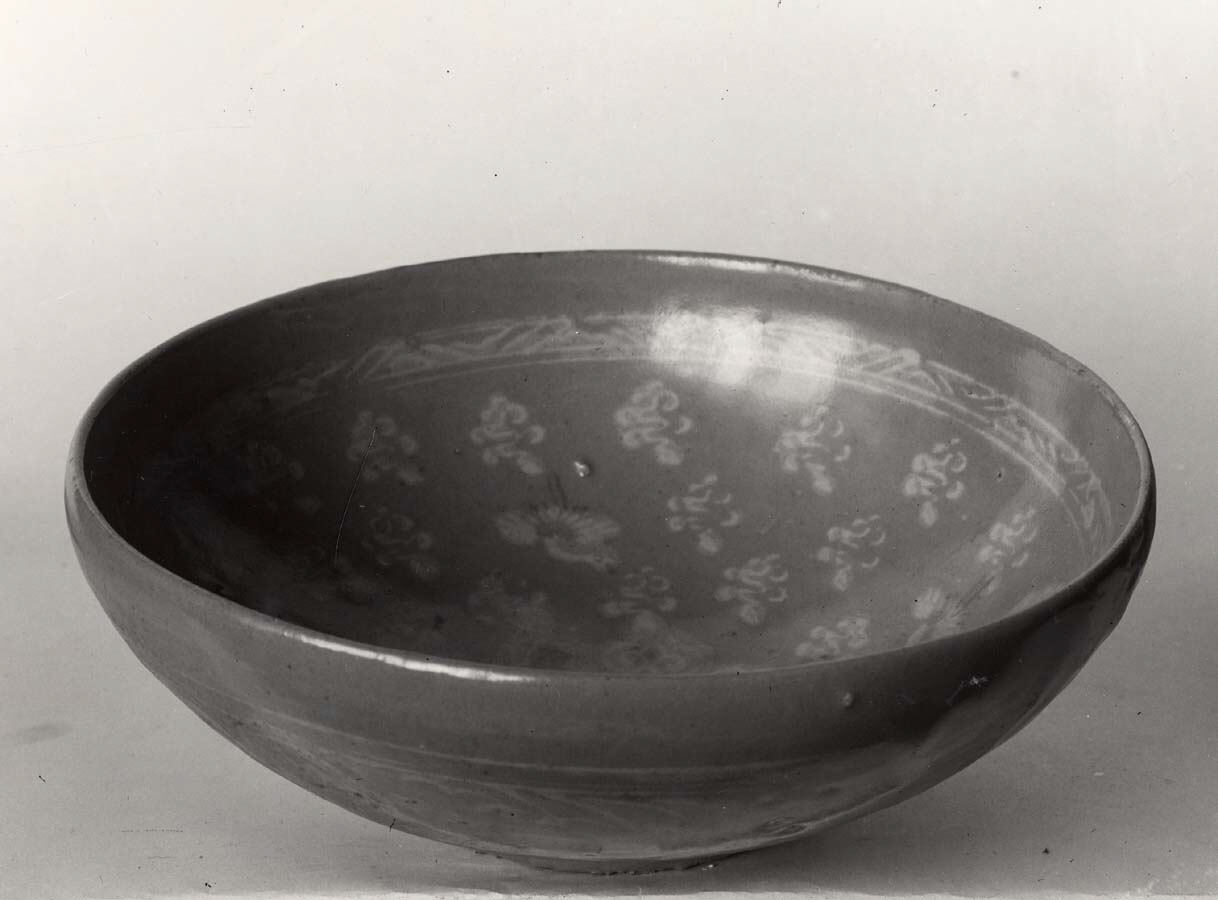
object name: bowl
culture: korean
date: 1201-1300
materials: clay